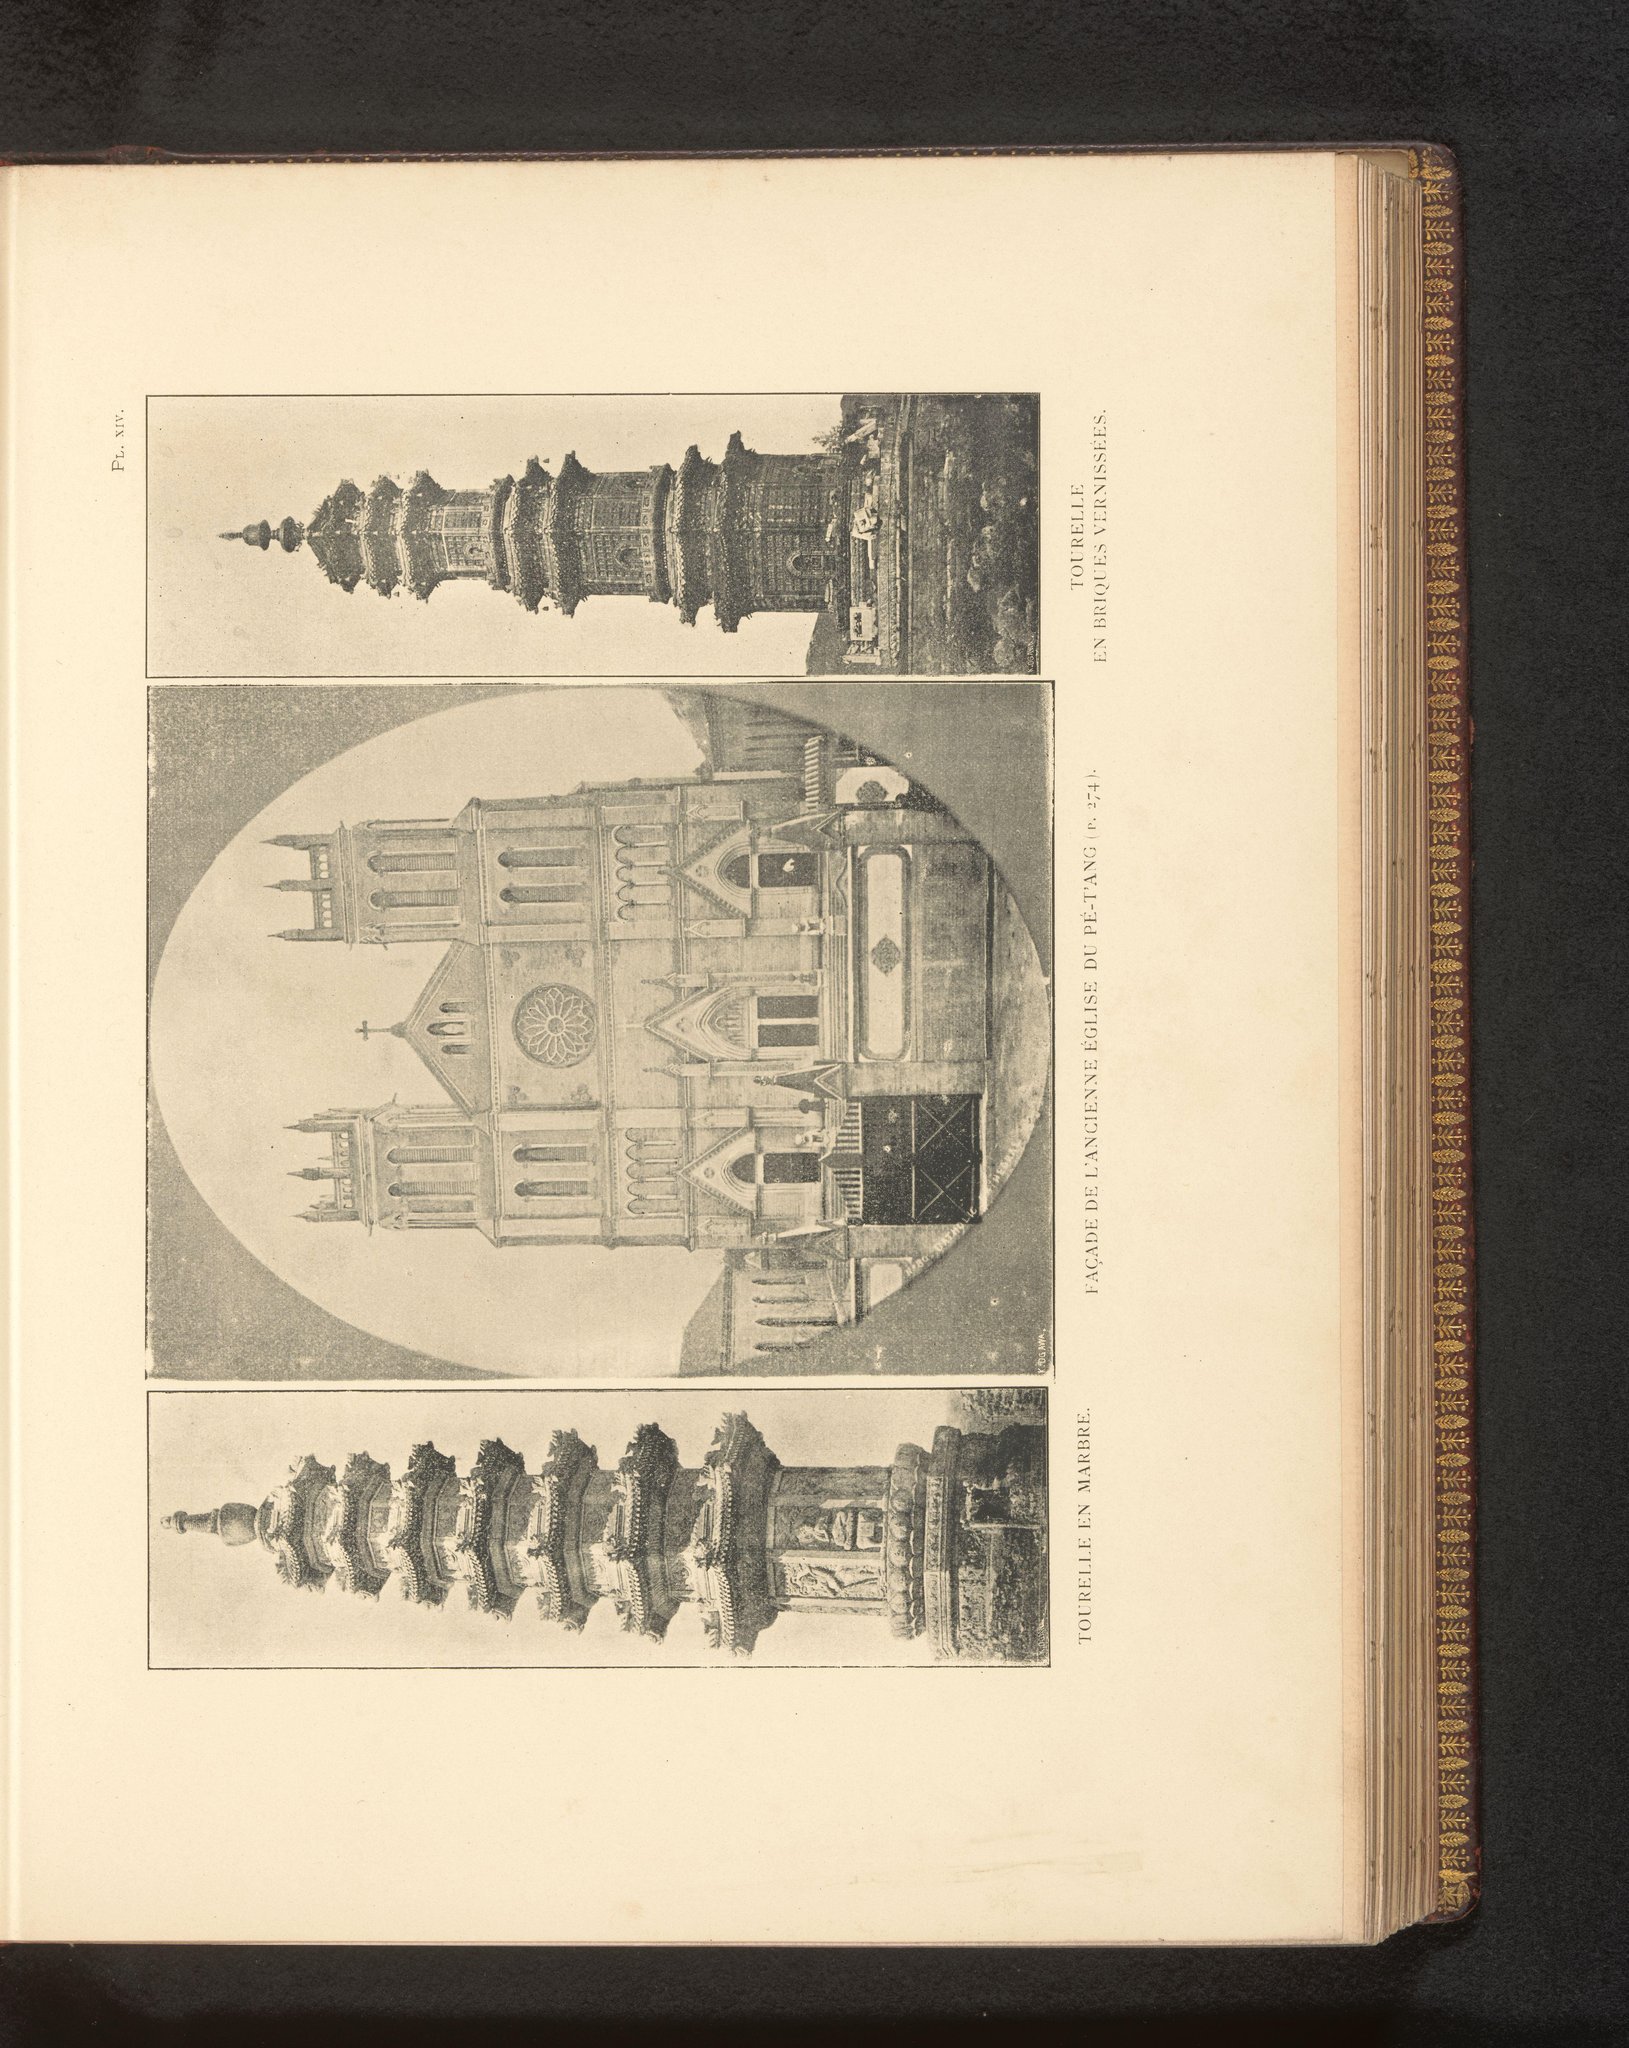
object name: page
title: Gezicht op een toren, Façade van de Xishiku-kerk en Gezicht op een toren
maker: Anonymous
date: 1892-1897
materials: paper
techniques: autotype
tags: landscape with tower or castle, front façade